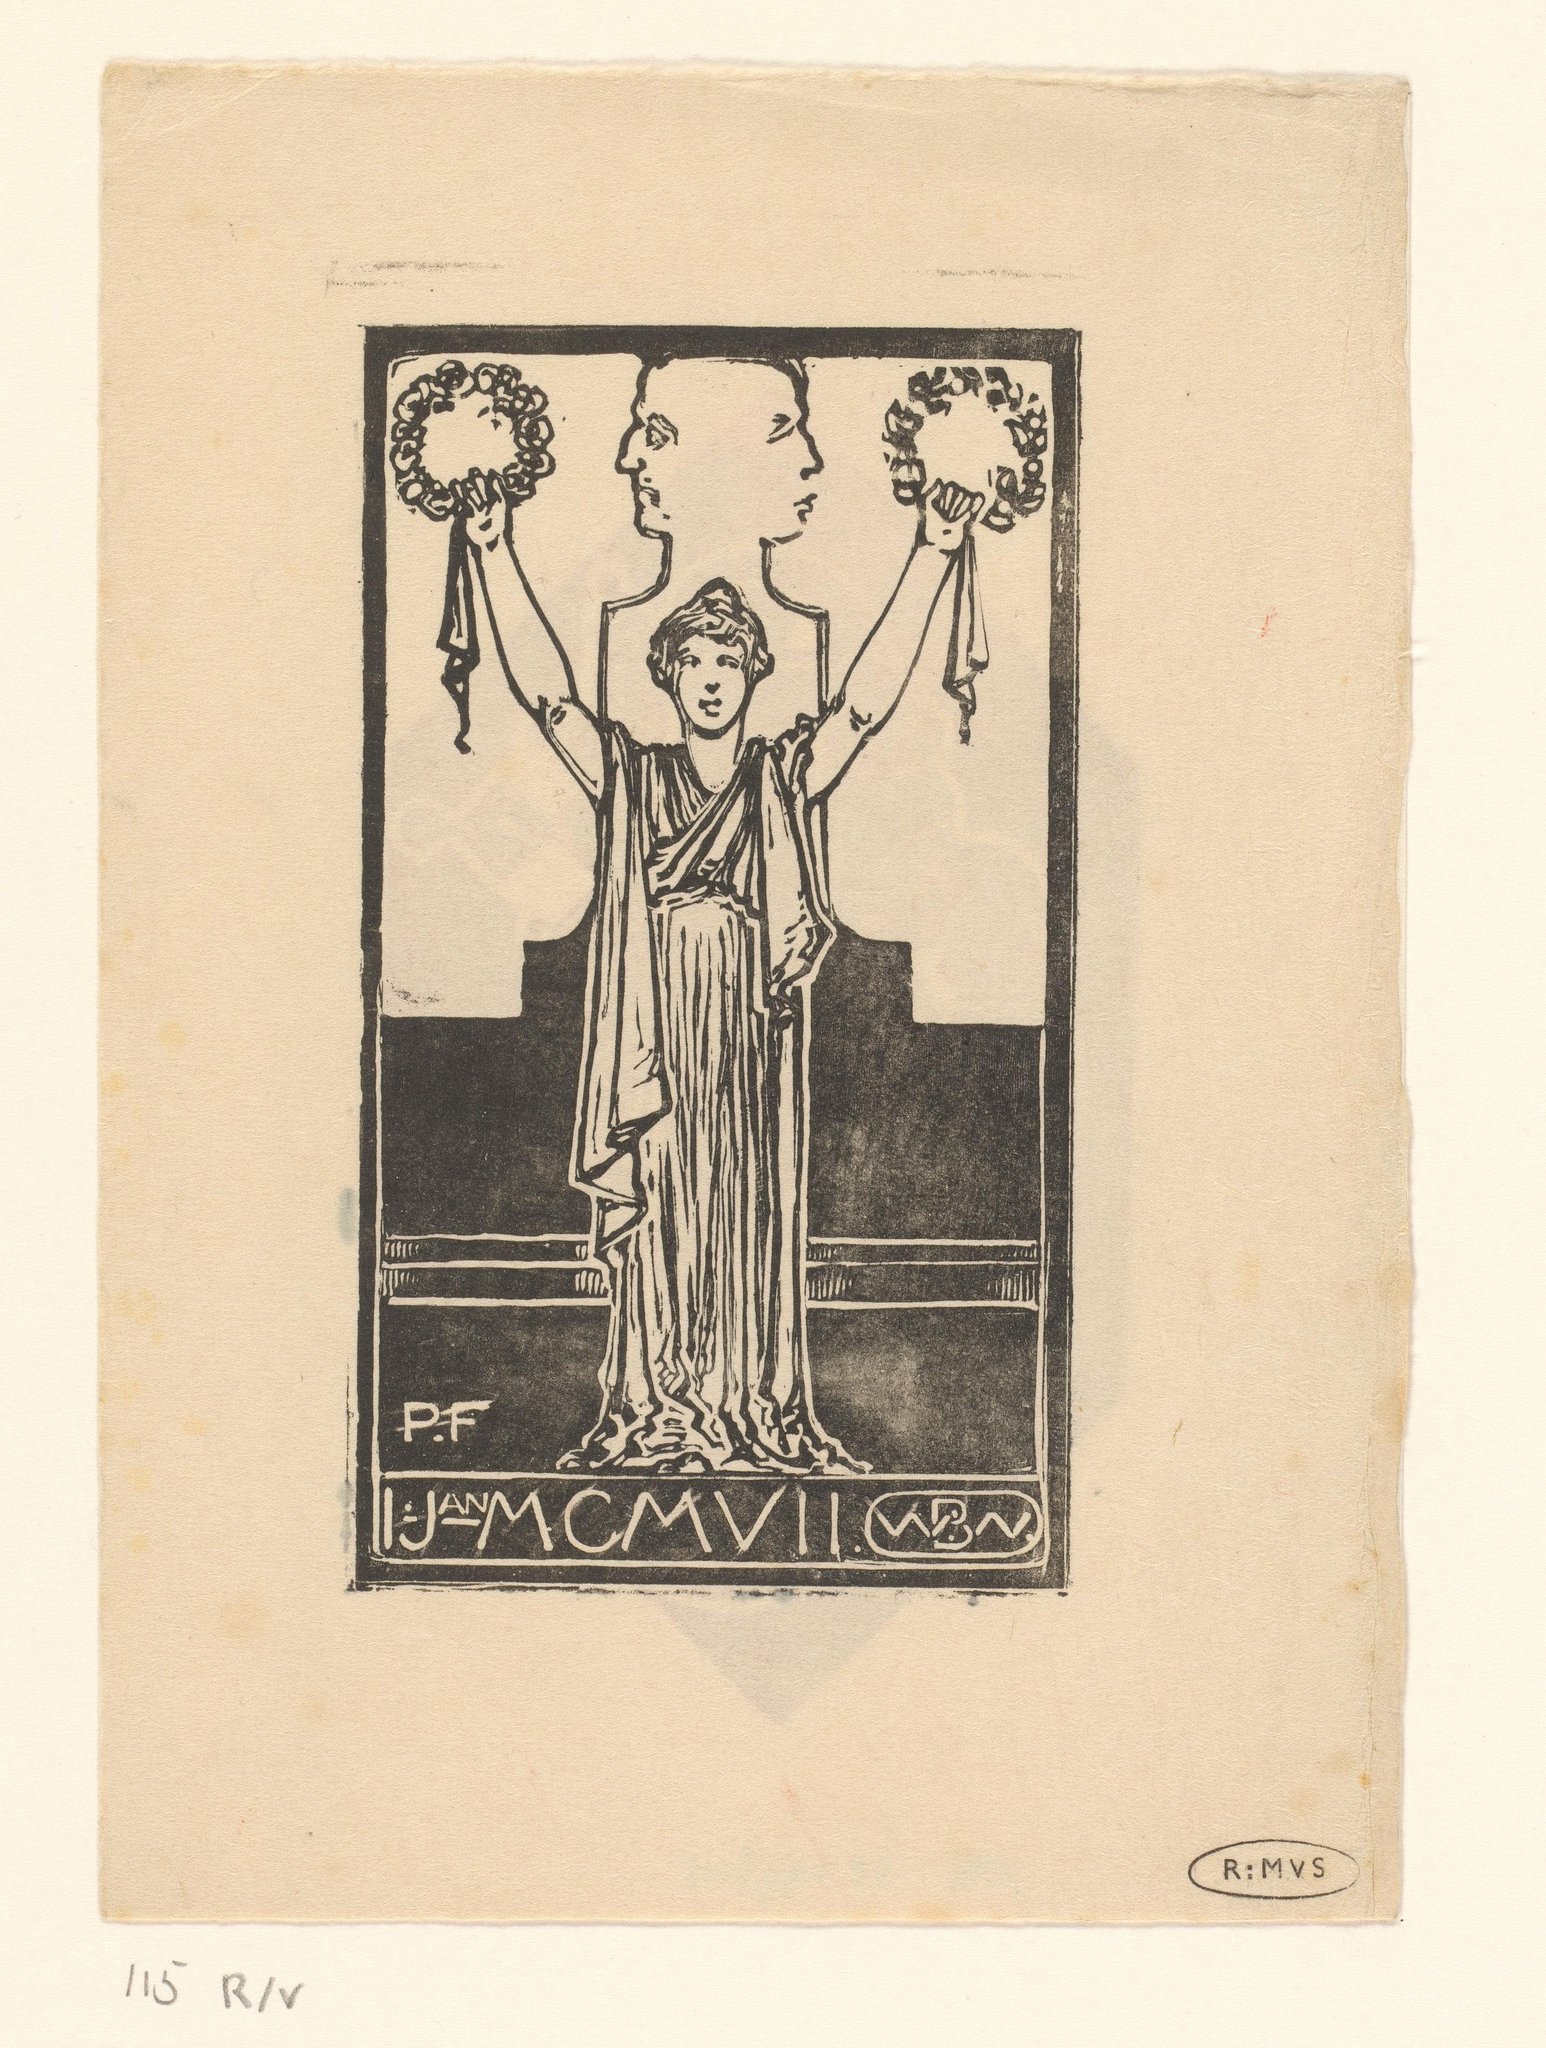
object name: print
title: Nieuwjaarswens voor 1907, met vrouw in Romeins gewaad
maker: bernard willem wierink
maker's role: draughtsman, print maker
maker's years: 1856-1939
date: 1906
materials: paper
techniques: relief print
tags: garland, wreath, (story of) the roman women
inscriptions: collector's mark: Lugt 2228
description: Deze prent is vermoedelijk een plaatsnede, ook al wordt in de literatuur veelal gesproken over een houtsnede. Voor zover Wierink zijn prenten in hoogdruk zelf nader heeft omschreven, heeft hij altijd de term 'plaatsnede' gebruikt.